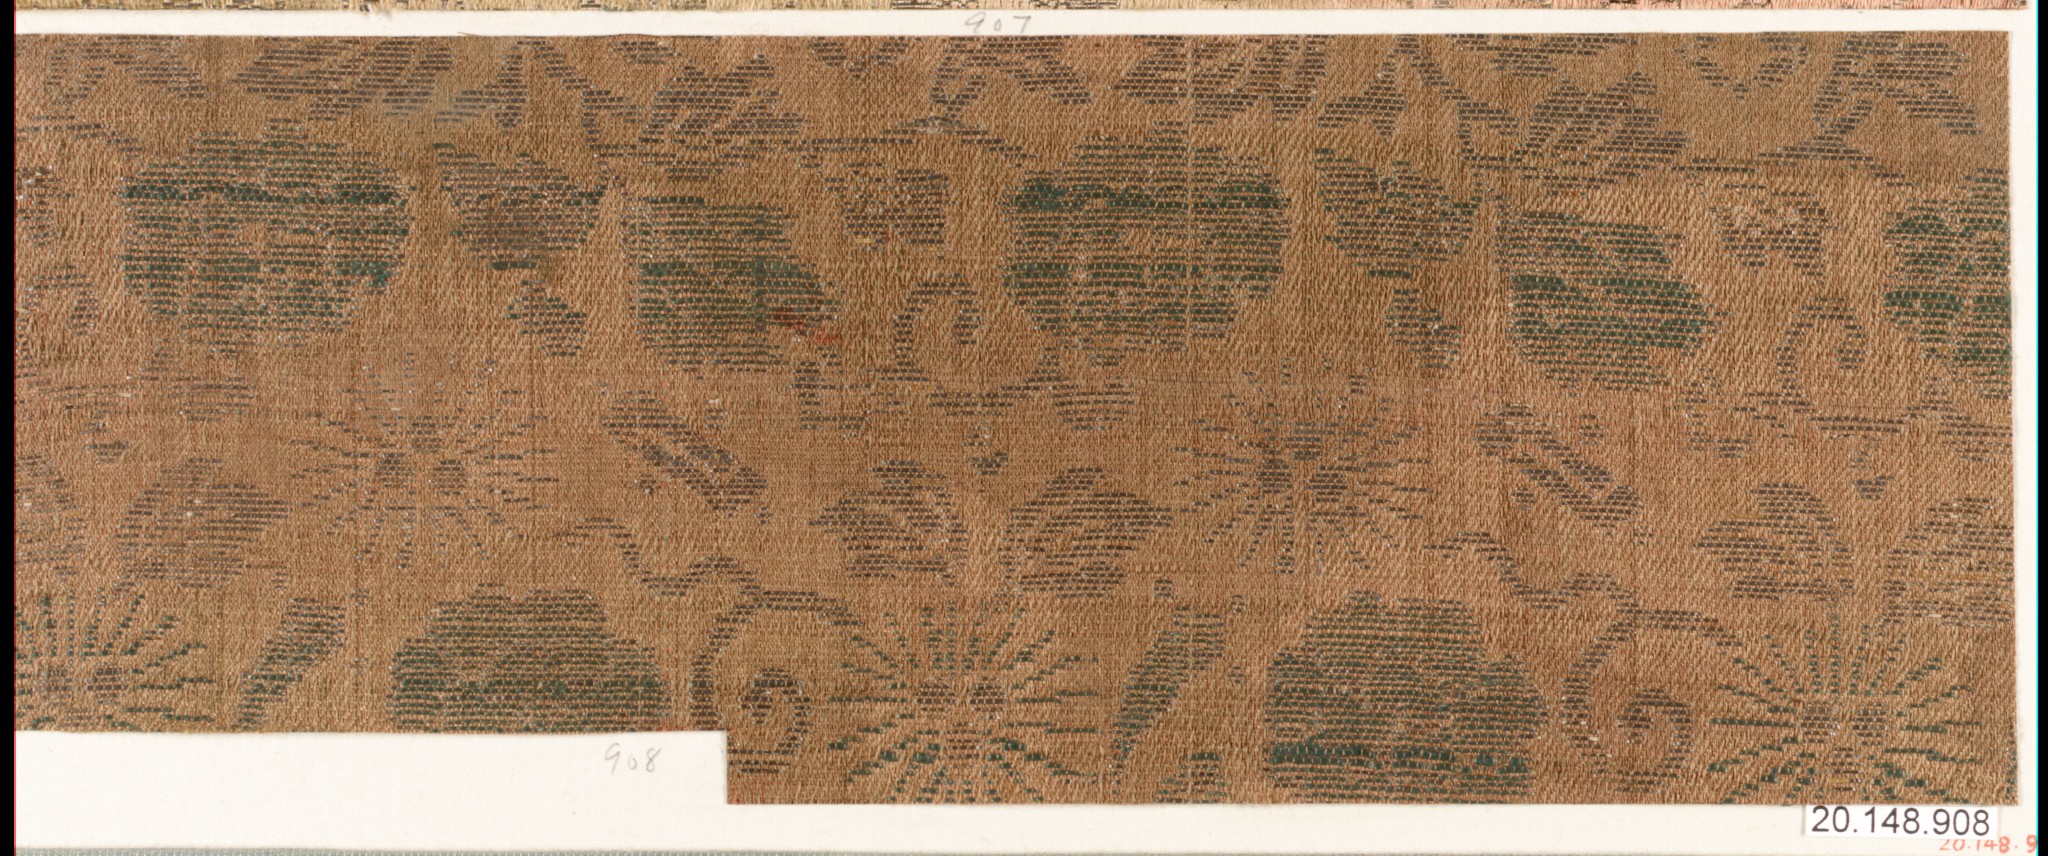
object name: piece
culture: japanese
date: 1701-1800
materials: silk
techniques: compound weave